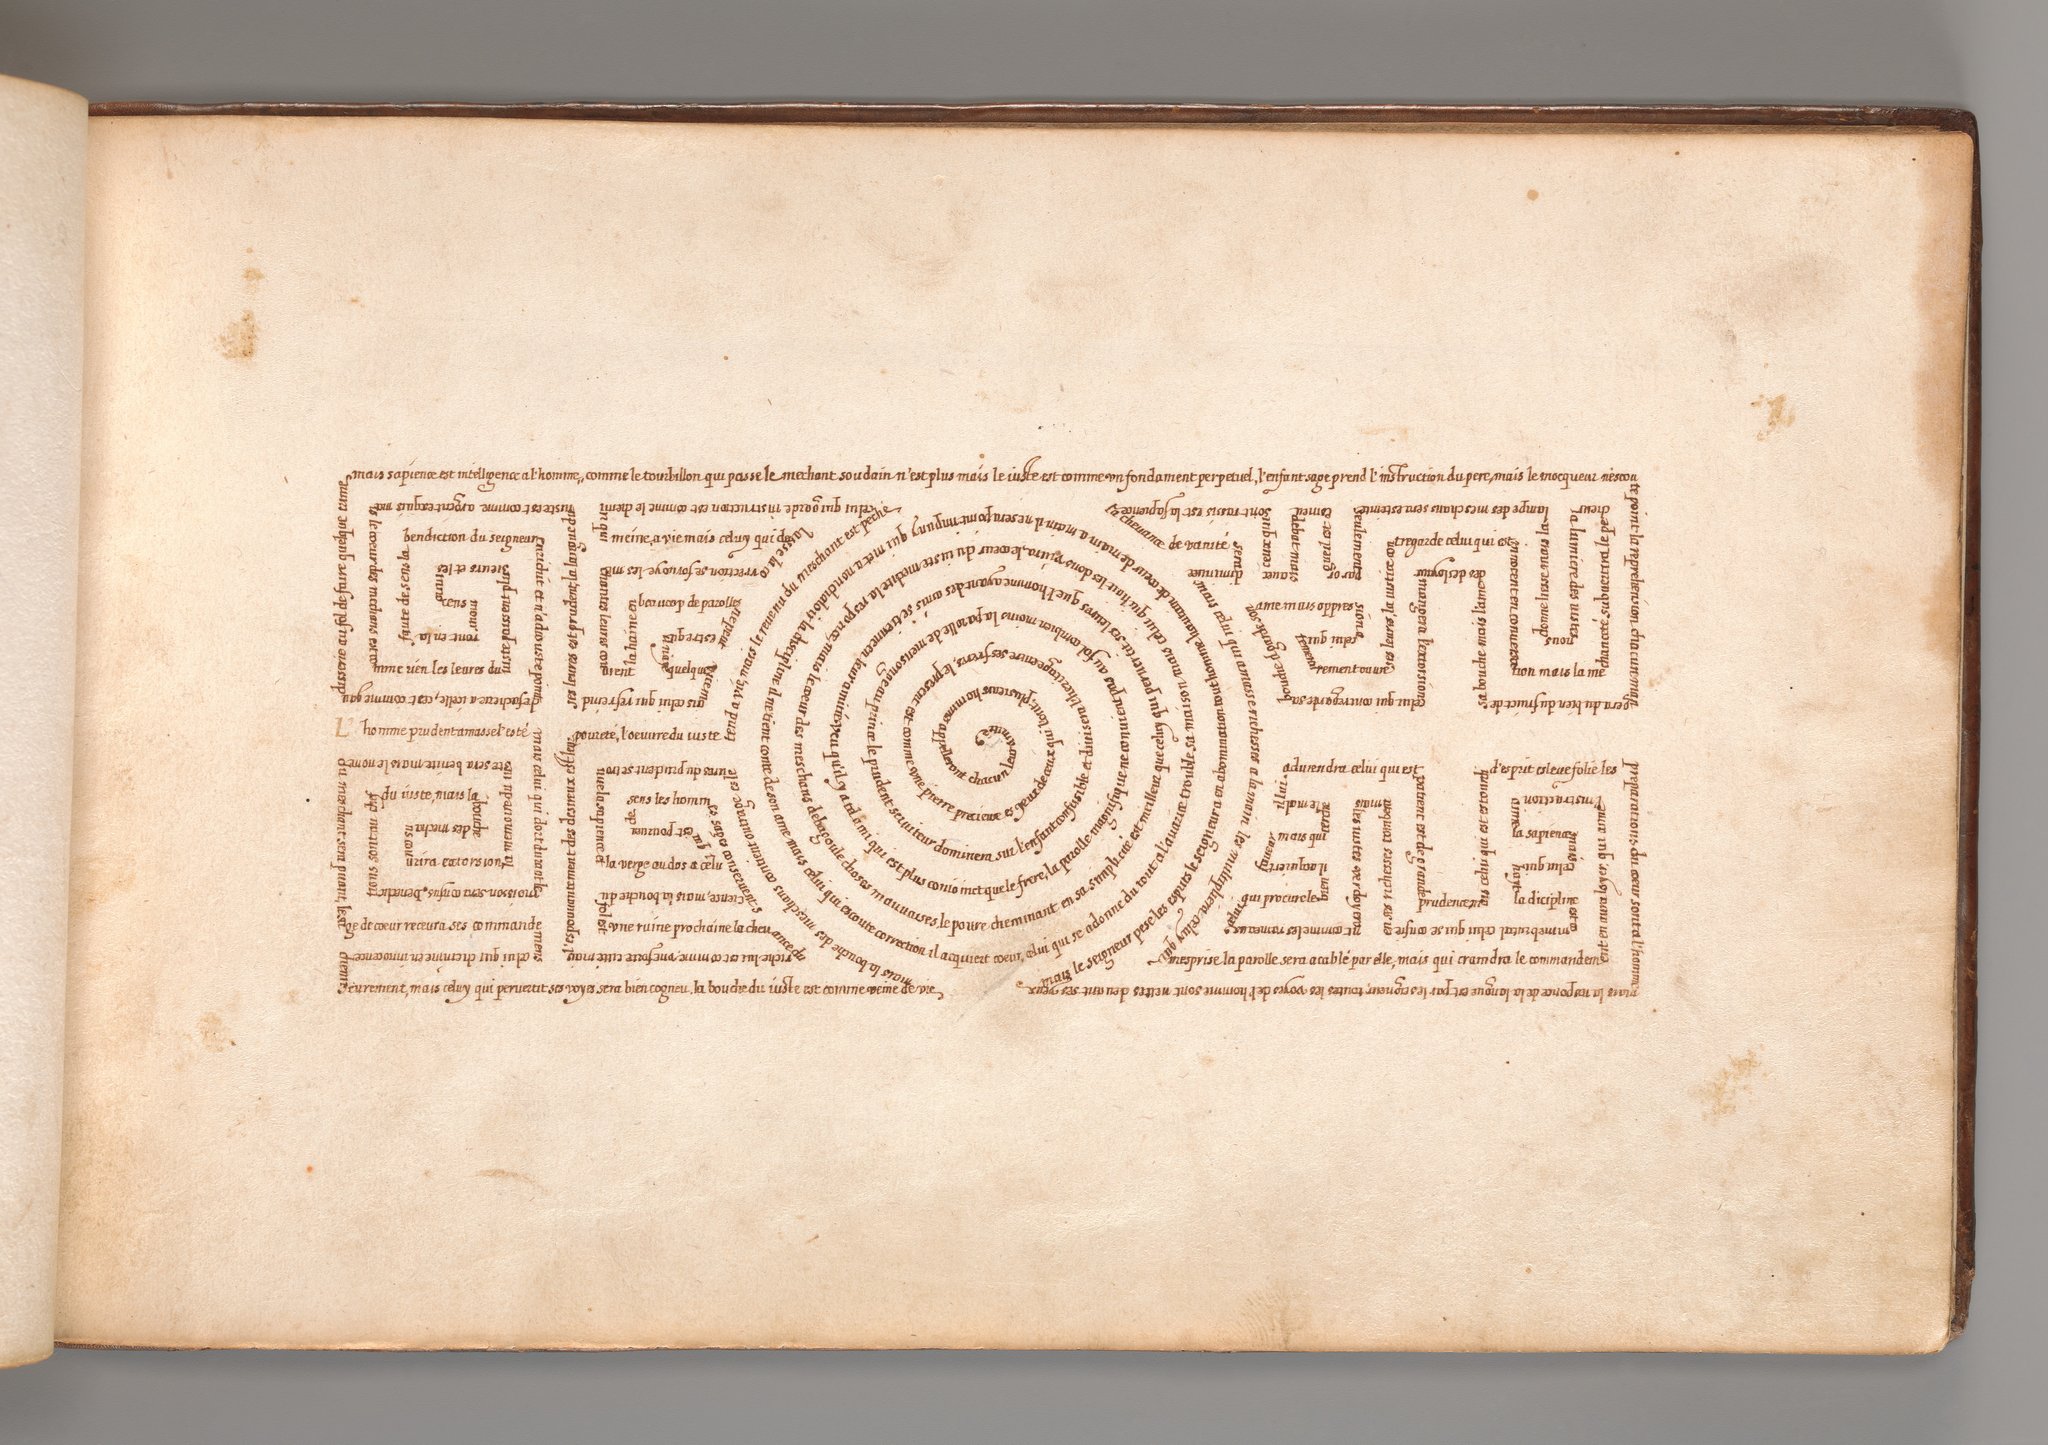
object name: album print ornament architecture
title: Album with Examples of Calligraphy and Micrography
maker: Anonymous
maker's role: artist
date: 1601-1633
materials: ink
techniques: pen